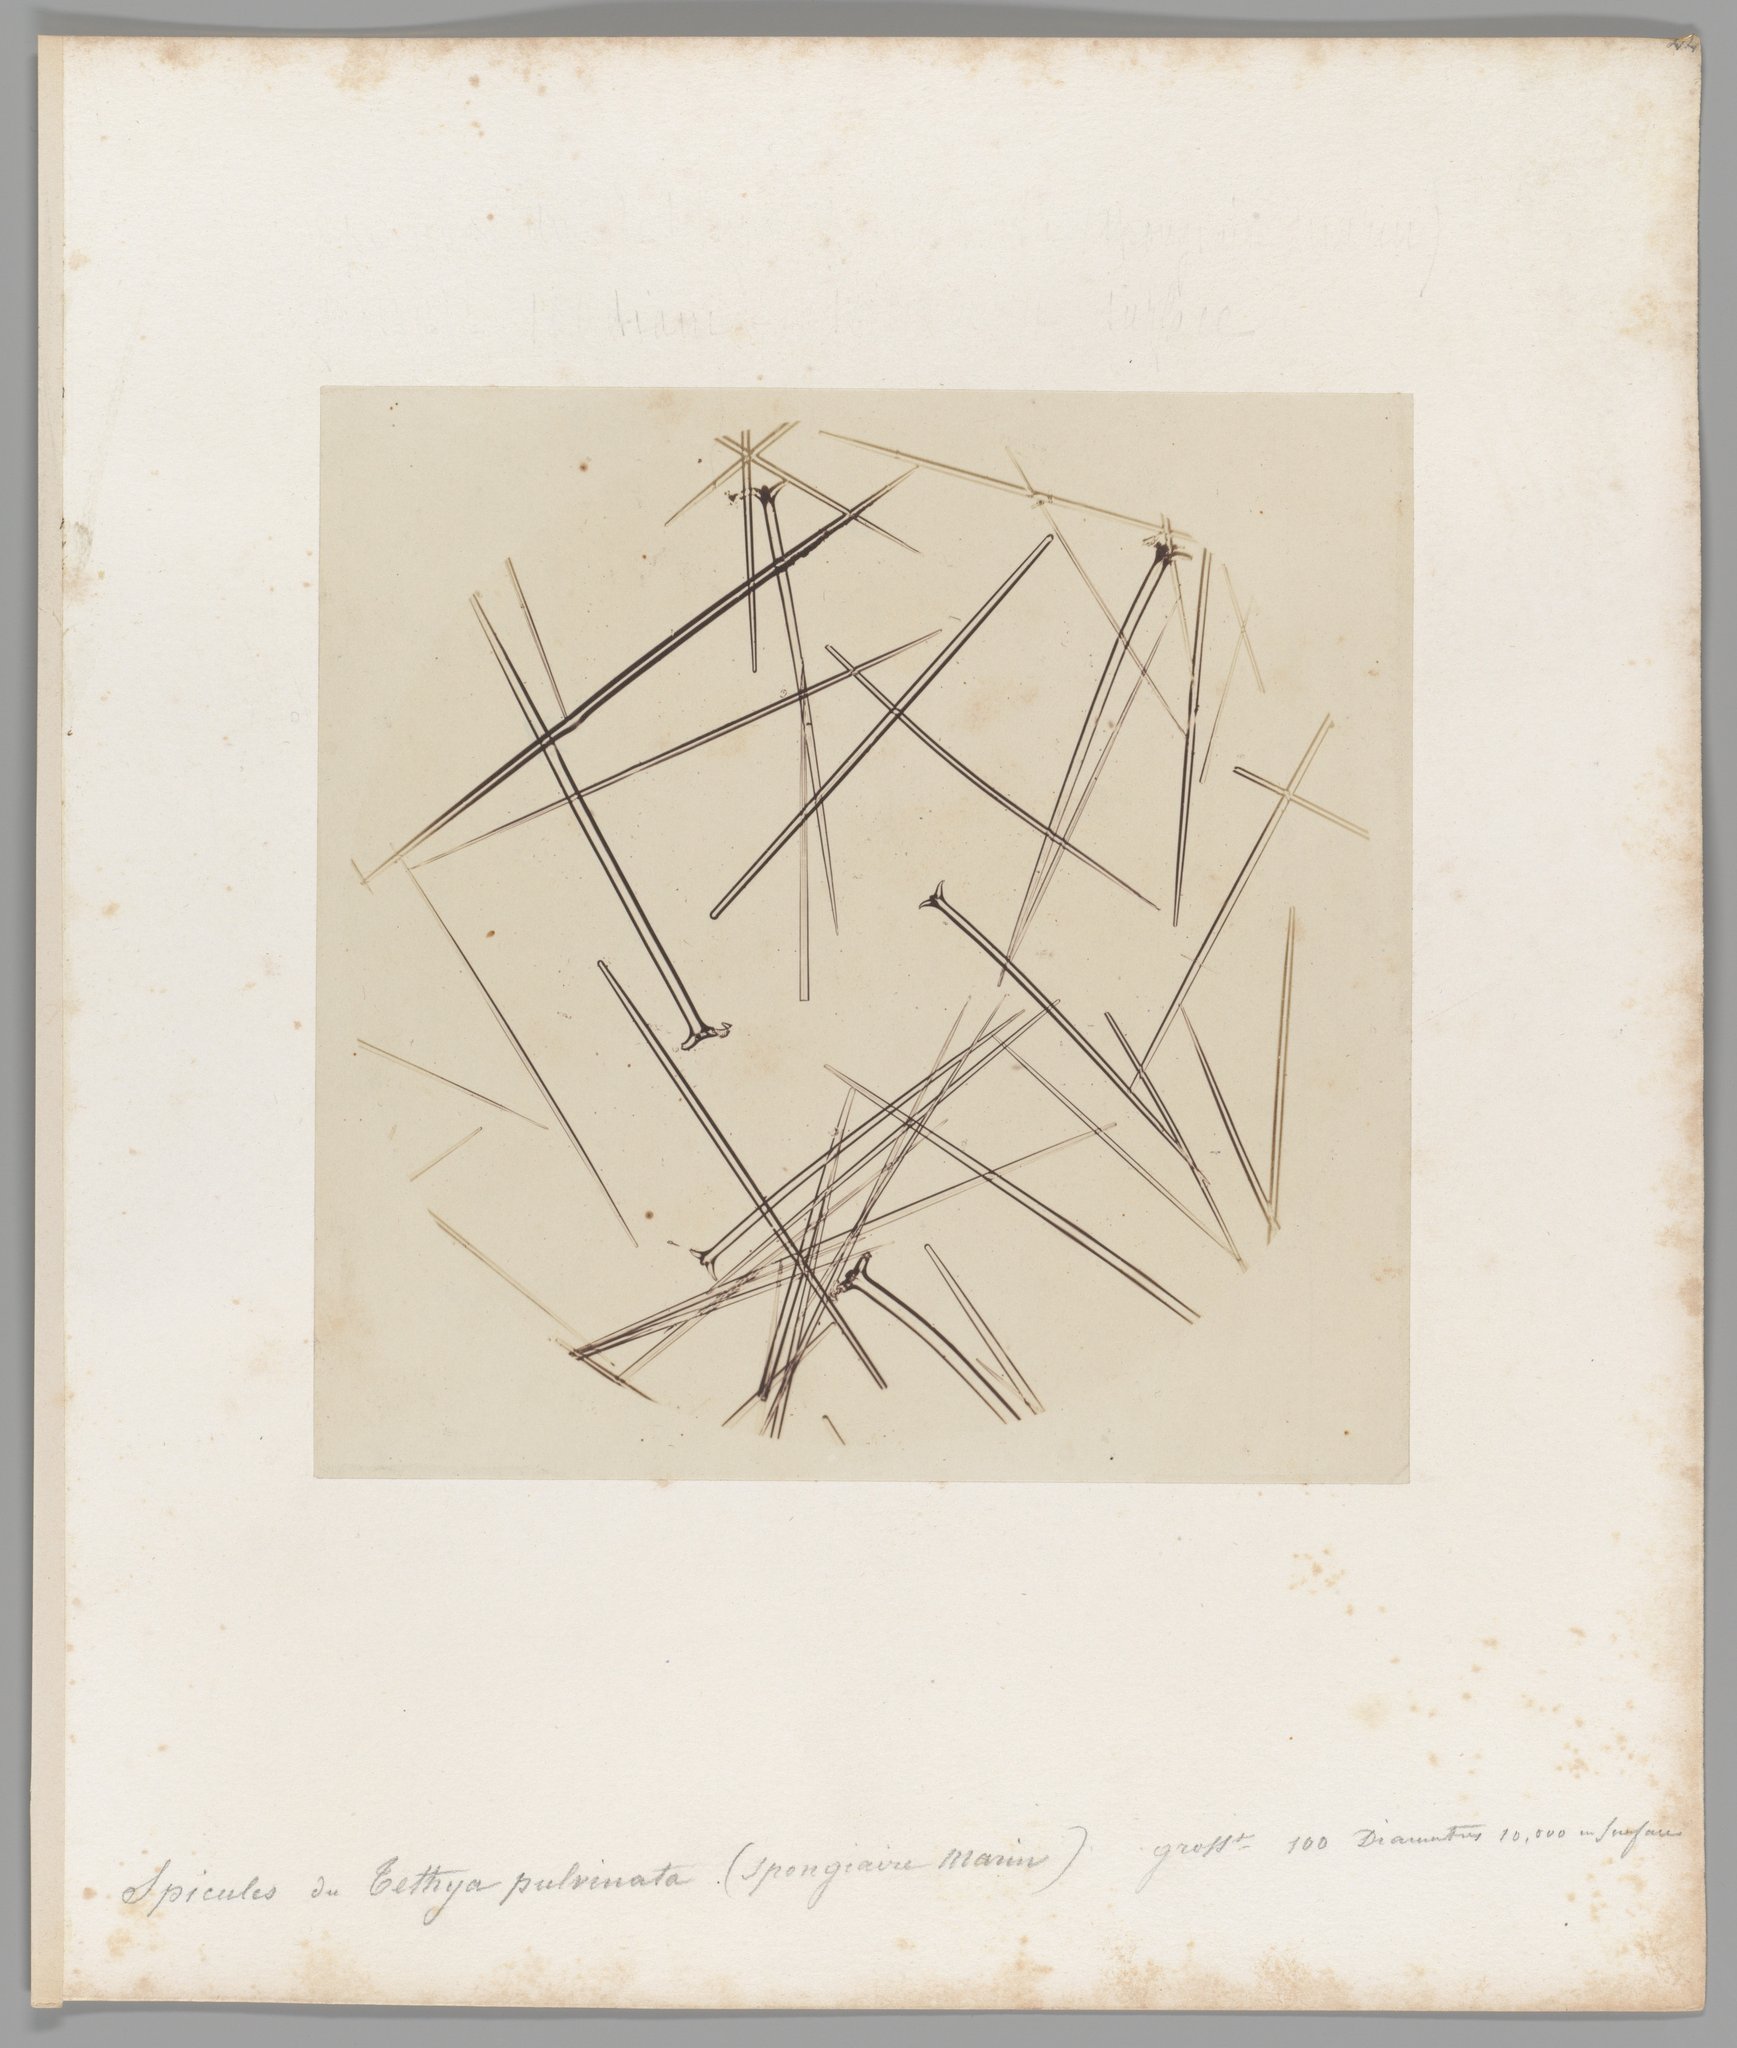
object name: photograph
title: [Untitled]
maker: auguste-adolphe bertsch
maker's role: artist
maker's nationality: french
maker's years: 1813-1871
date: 1853-1857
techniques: salted paper print